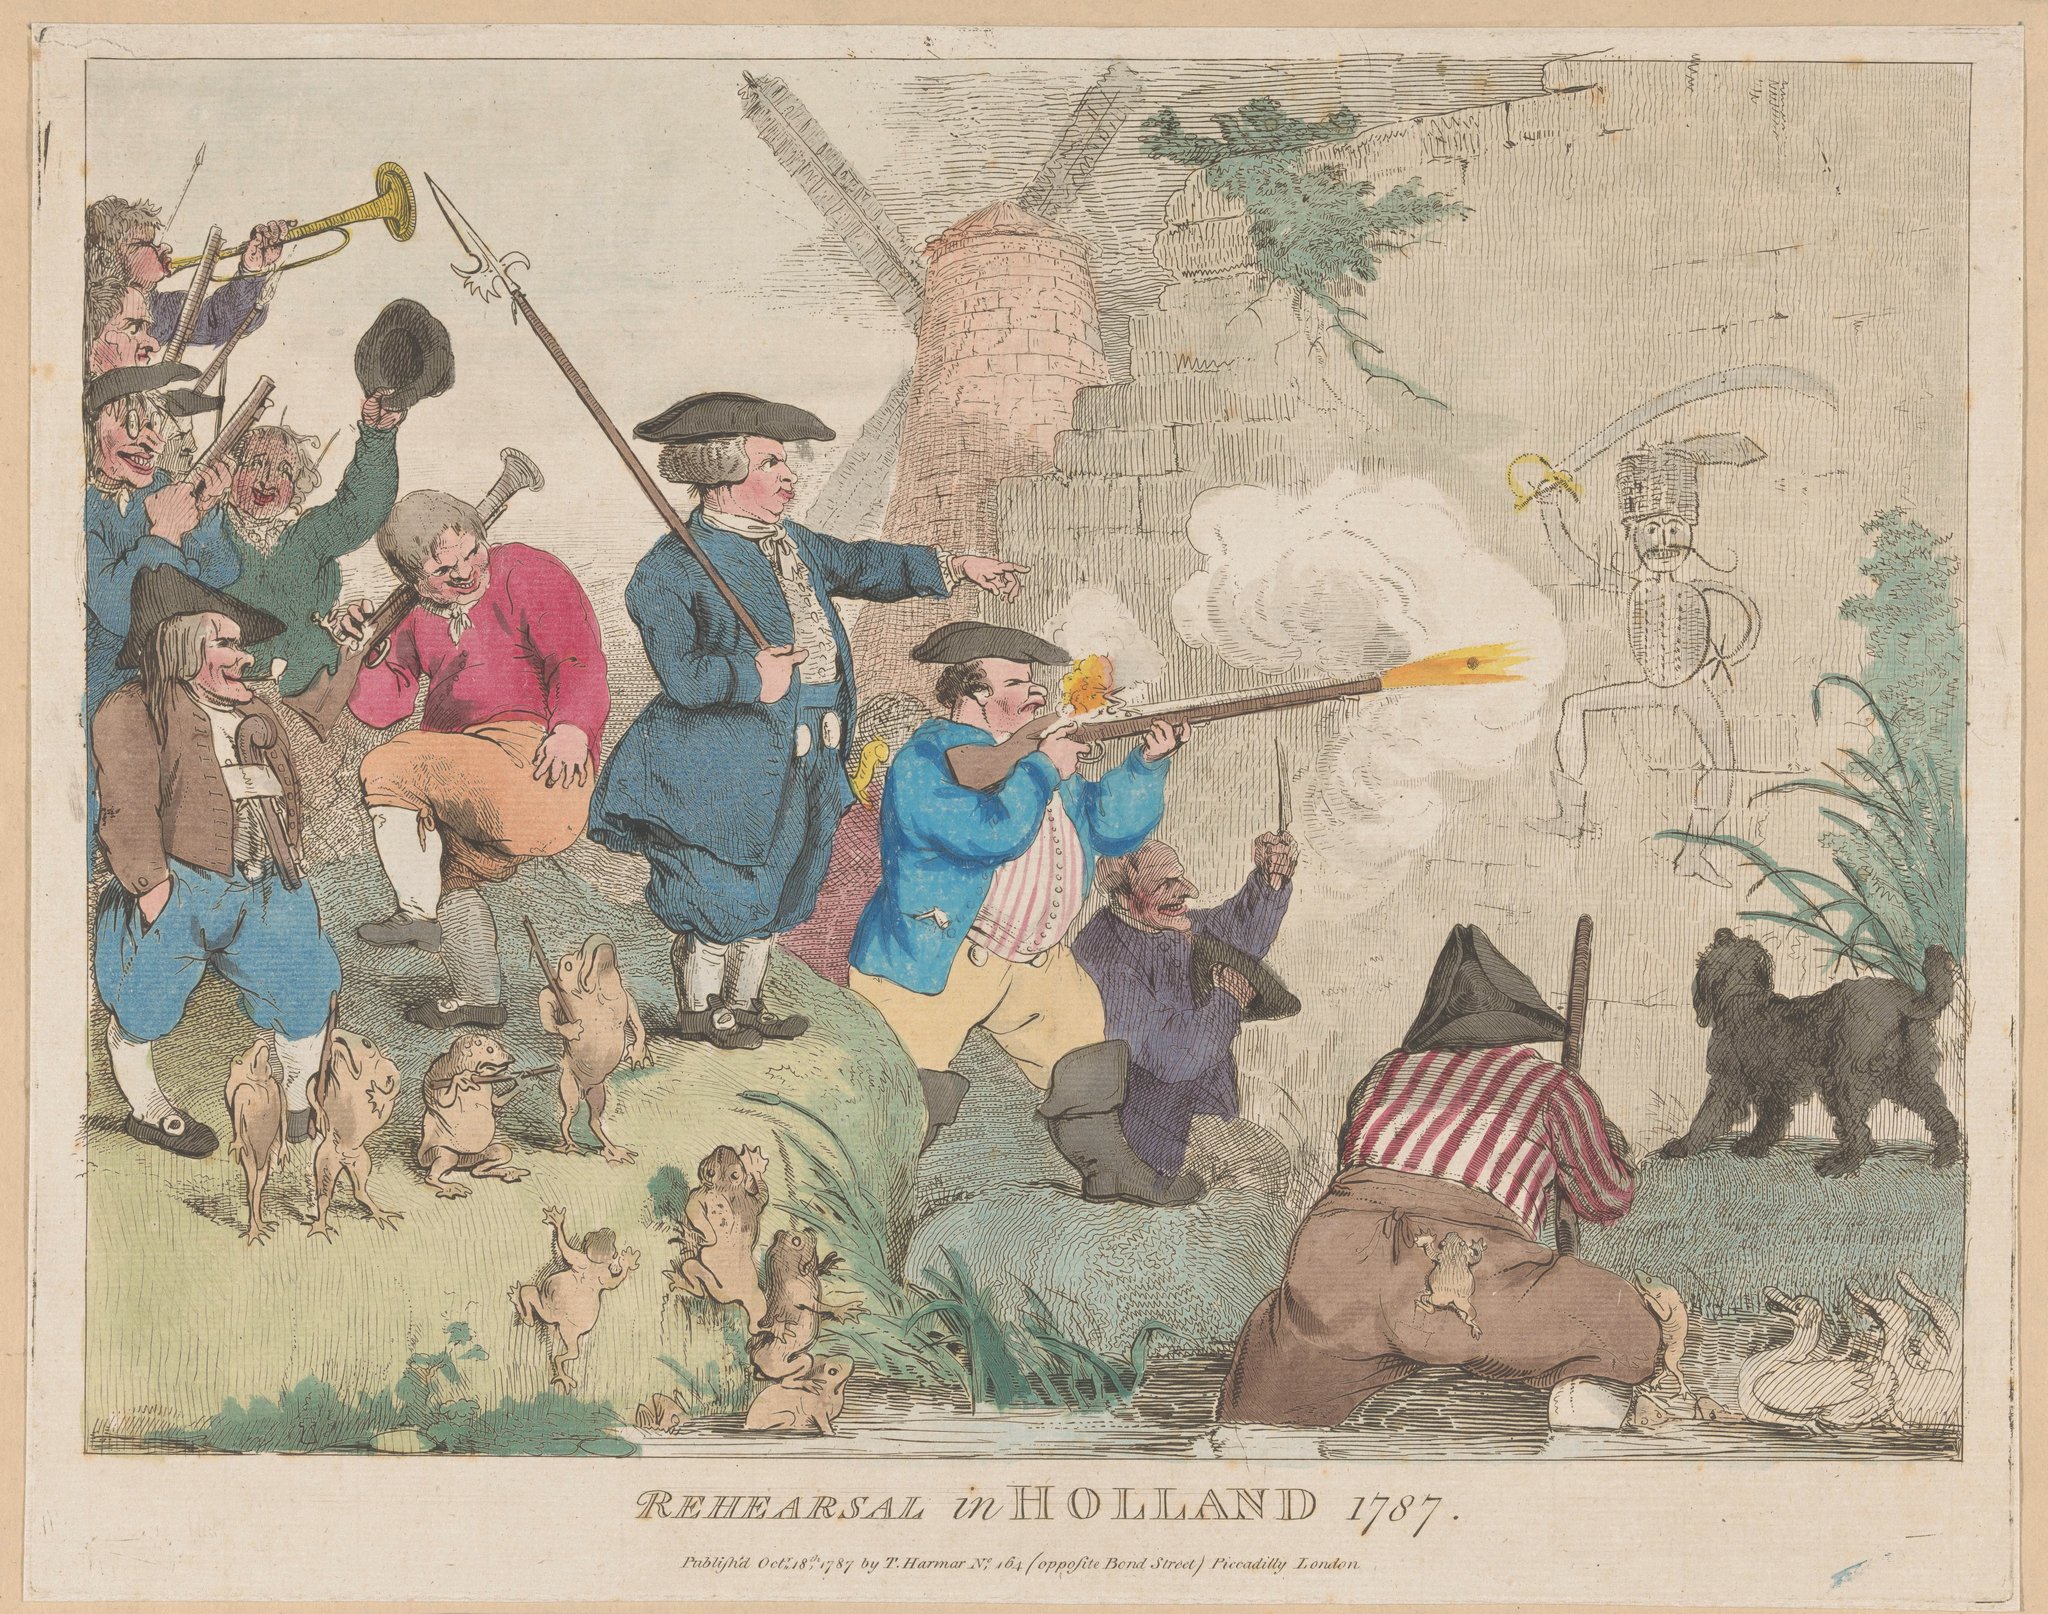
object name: cartoon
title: Rehearsal in Holland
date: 1787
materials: paper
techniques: etching, hand coloring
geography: england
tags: tailless amphibians: frog, military training (+ citizen soldiery, civil guard, citizen militia), animals acting as human beings, political caricatures and satires, patriots (1780-1795)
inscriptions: collector's mark: Lugt 2233, collector's mark: Lugt 2228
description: The rise of the Dutch Patriot faction led to the creation of civic militias in which civilians were trained to use weapons. On 28 June 1787, things got out of hand when Stadtholder William V’s wife, Princess Wilhelmina of Prussia, was detained by armed Patriots at Goejanverwellesluis. In this print, Patriots disdainfully taunt and shoot at the figure of an angry Prussian hussar drawn on the wall.